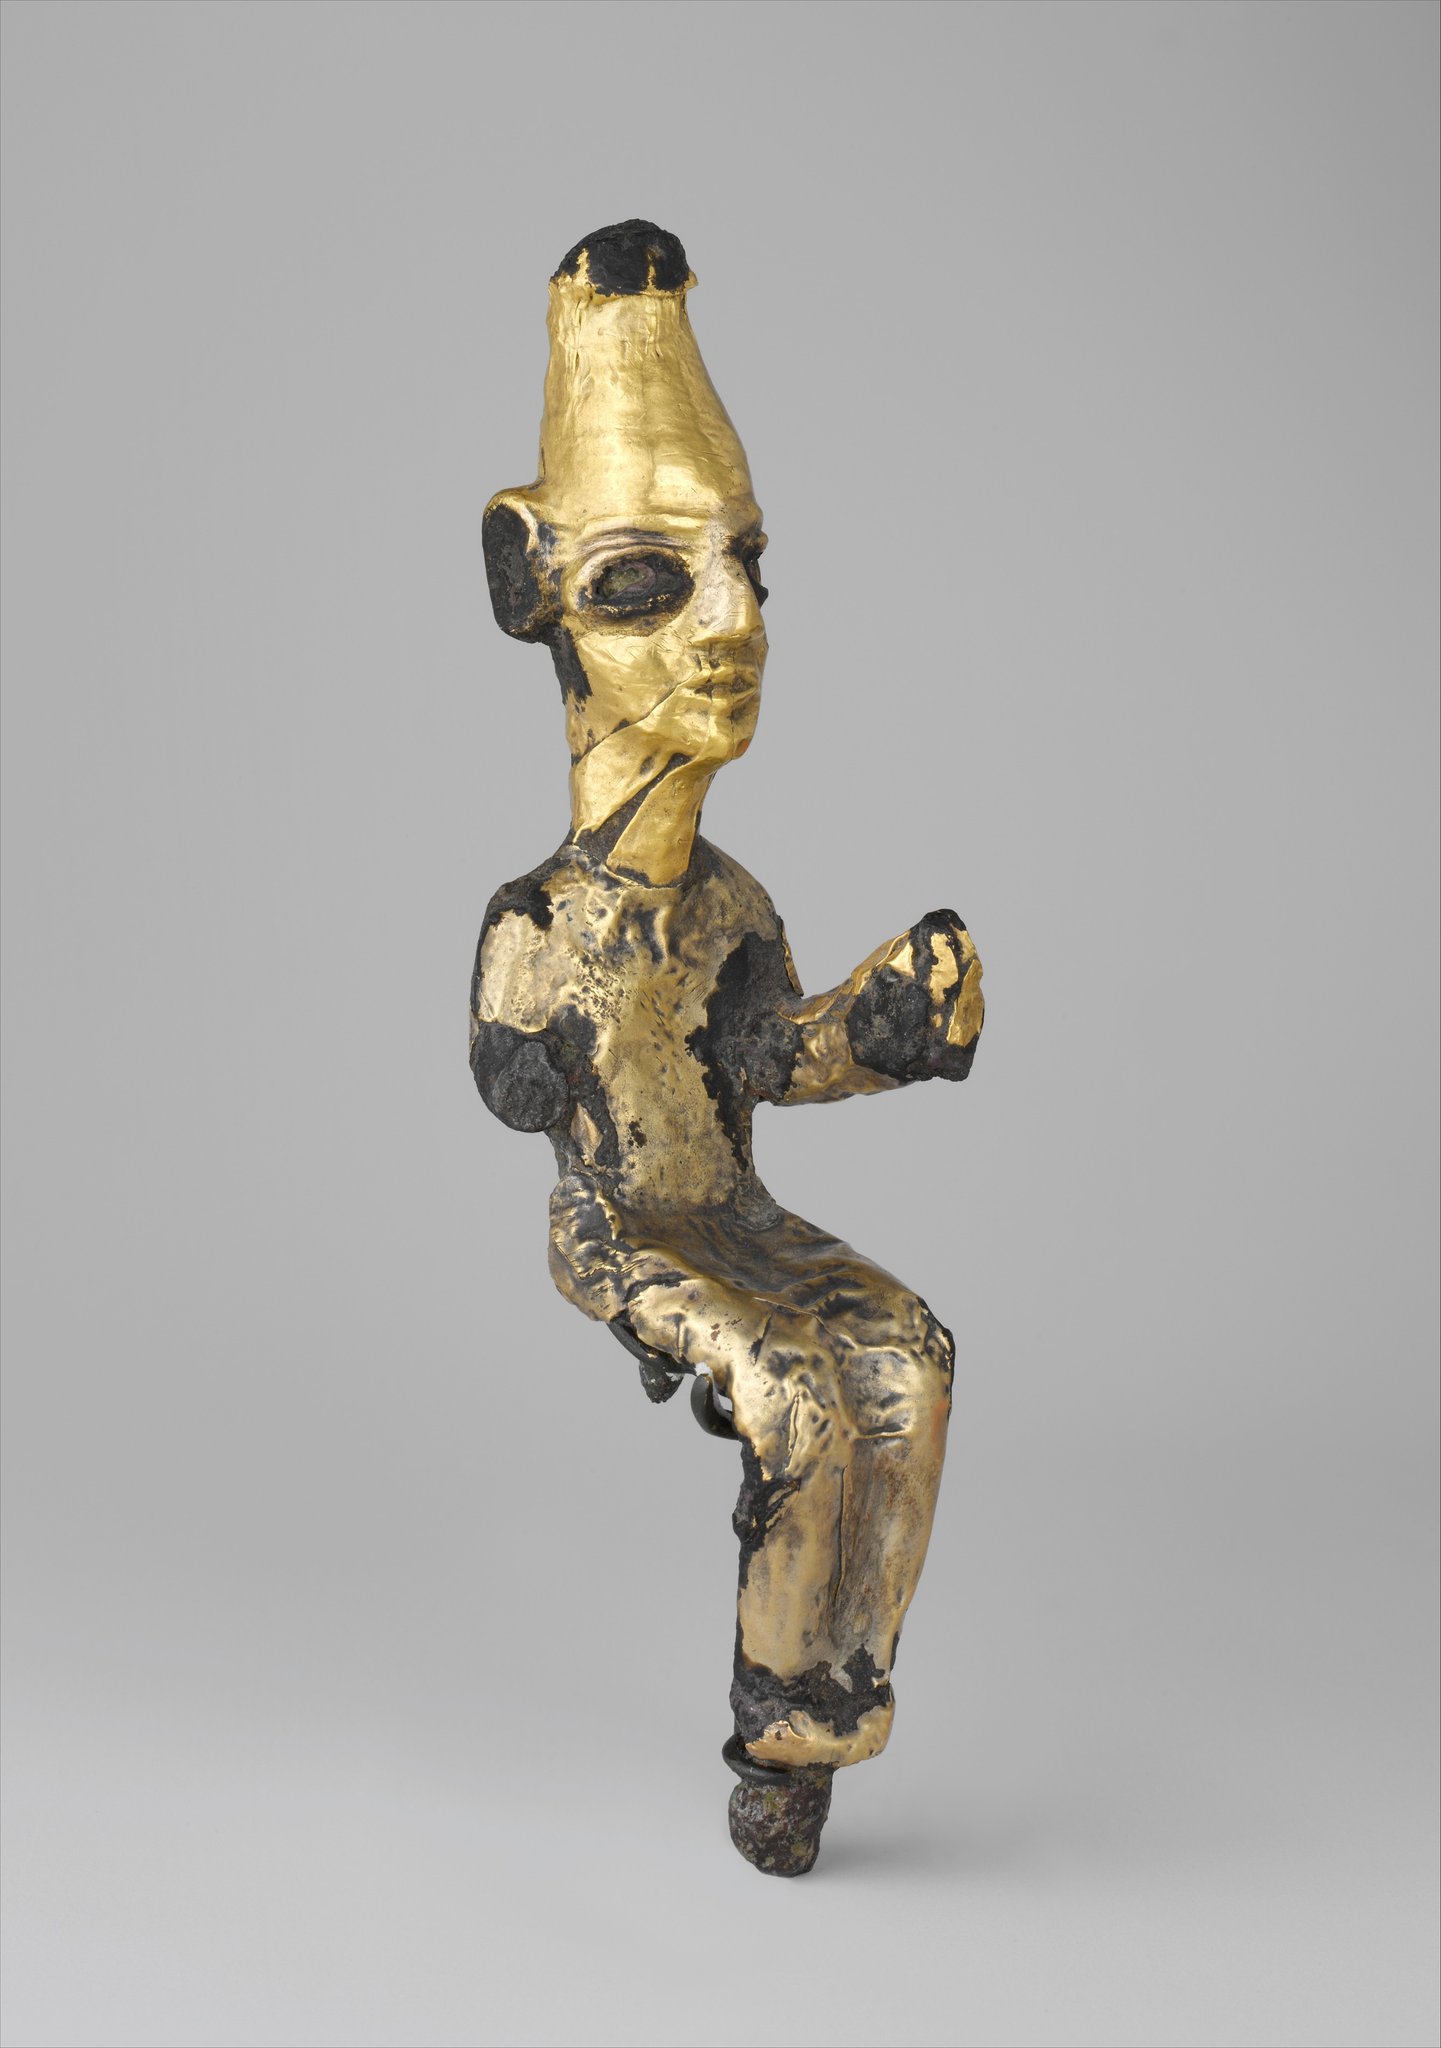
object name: sculpture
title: Enthroned deity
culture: canaanite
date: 1400-1201 BCE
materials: bronze, gold foil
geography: levant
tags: men,deities